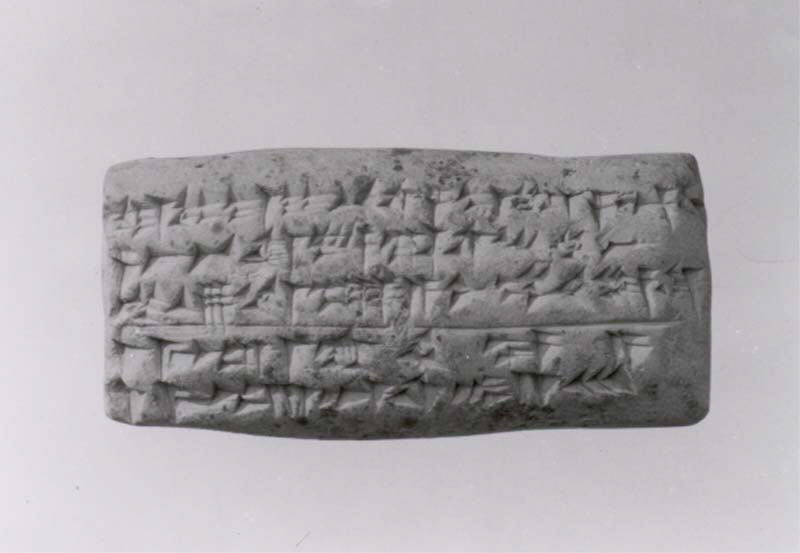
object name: cuneiform tablet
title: Cuneiform tablet: account of dates as imittu-rent, Ebabbar archive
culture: babylonian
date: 606 BCE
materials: clay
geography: mesopotamia